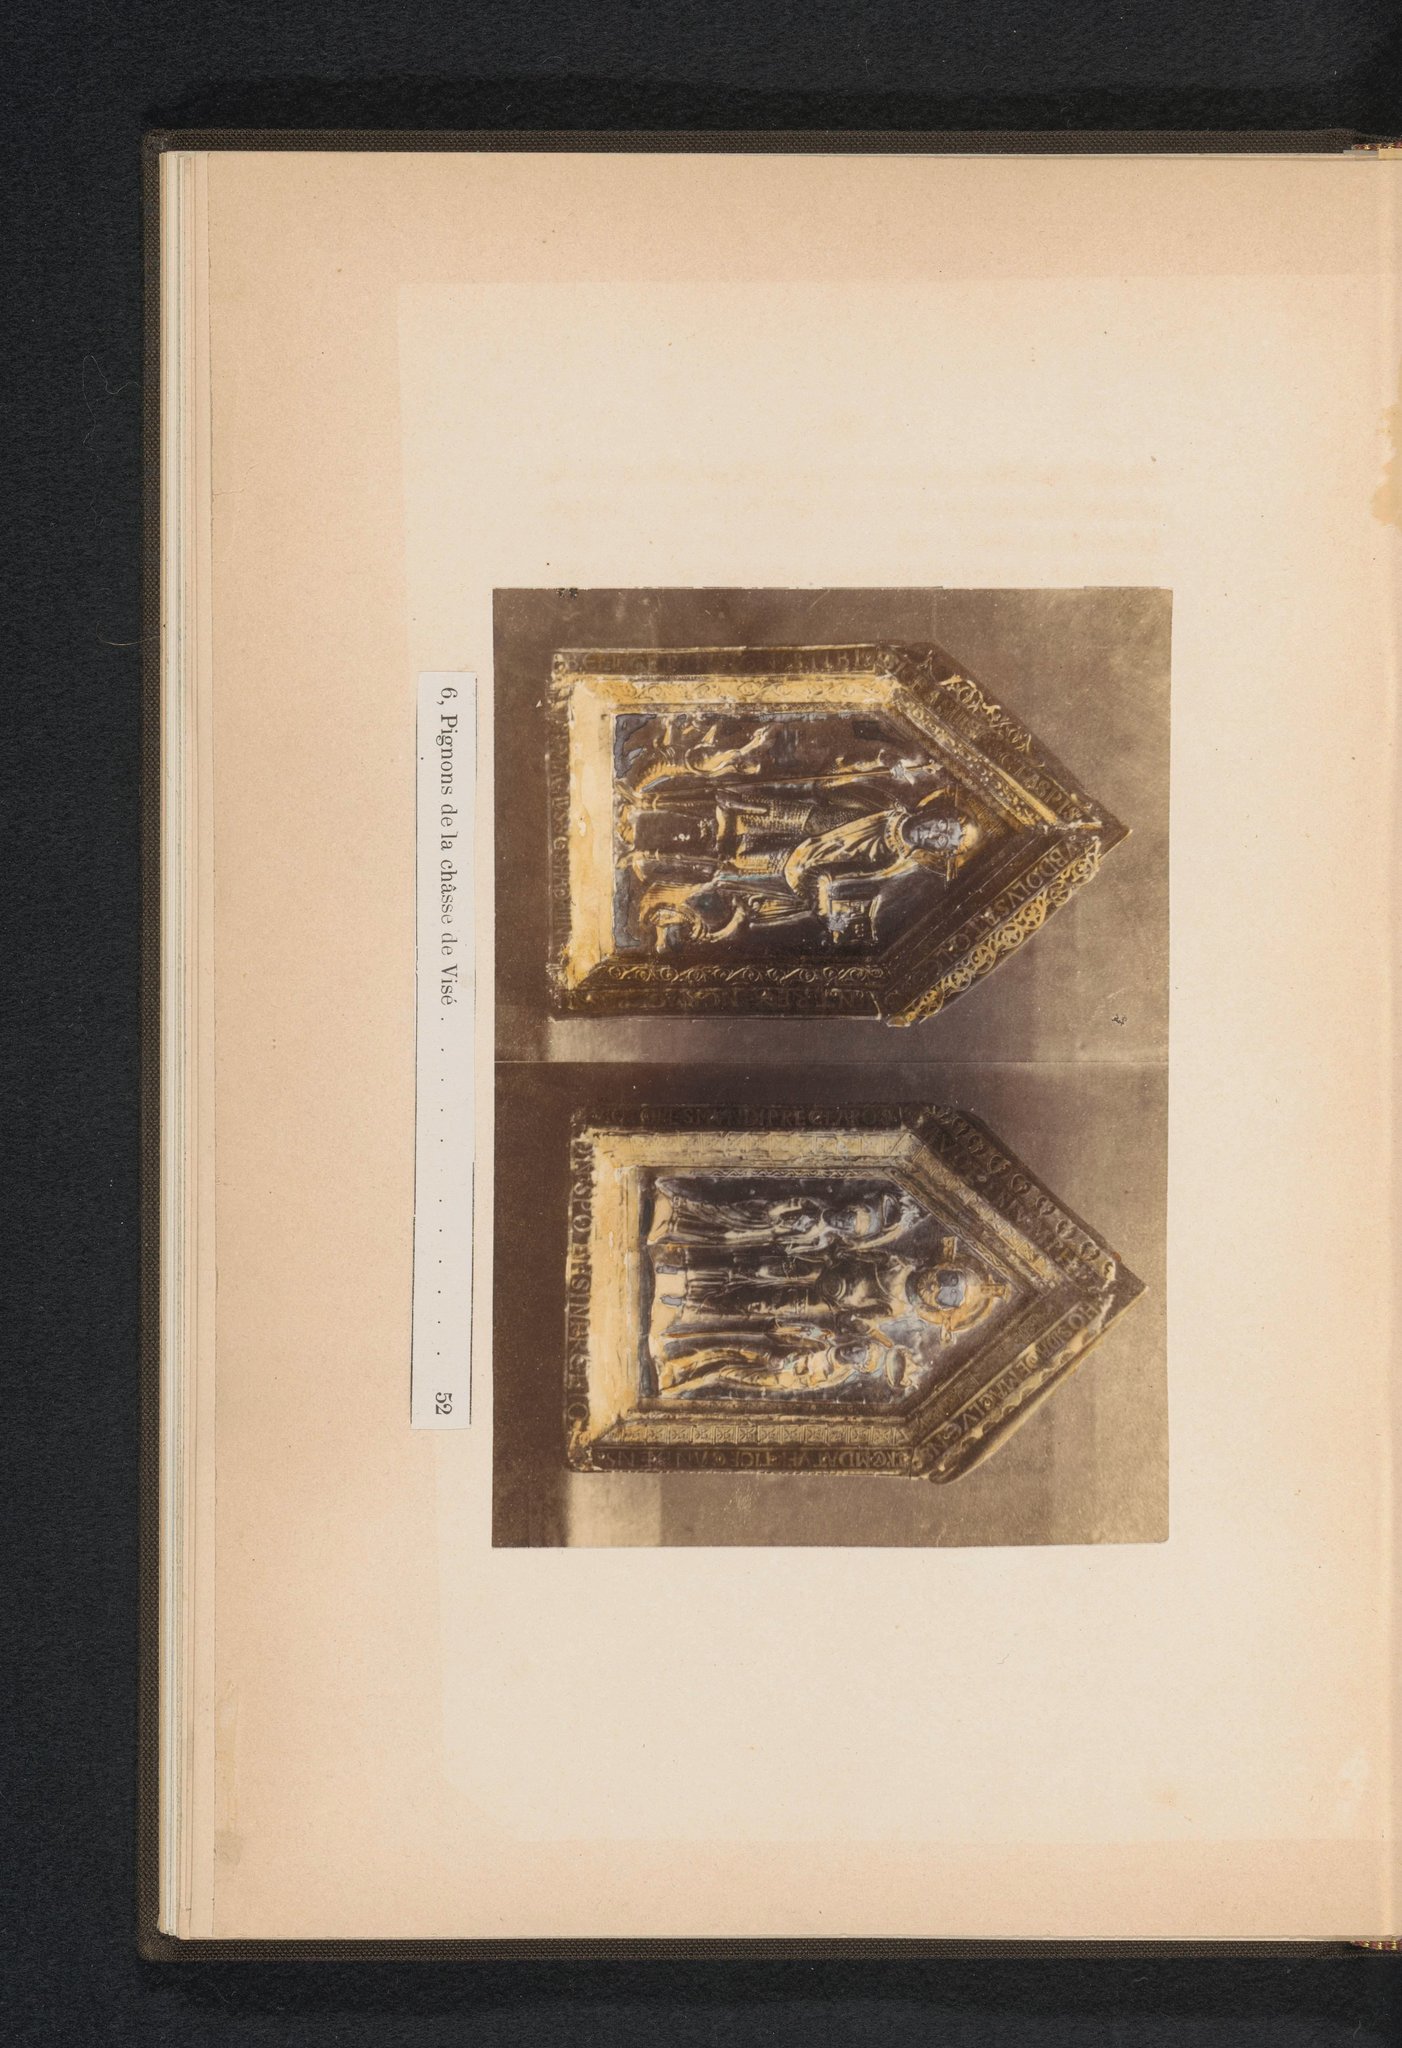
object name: photograph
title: Pignons de la châsse de Visé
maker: Anonymous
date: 1877-1882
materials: photographic support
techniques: albumen print, hand coloring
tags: adult christ together with apostles, evangelists, saints, etc., sculpture (+ relief ~ sculpture)